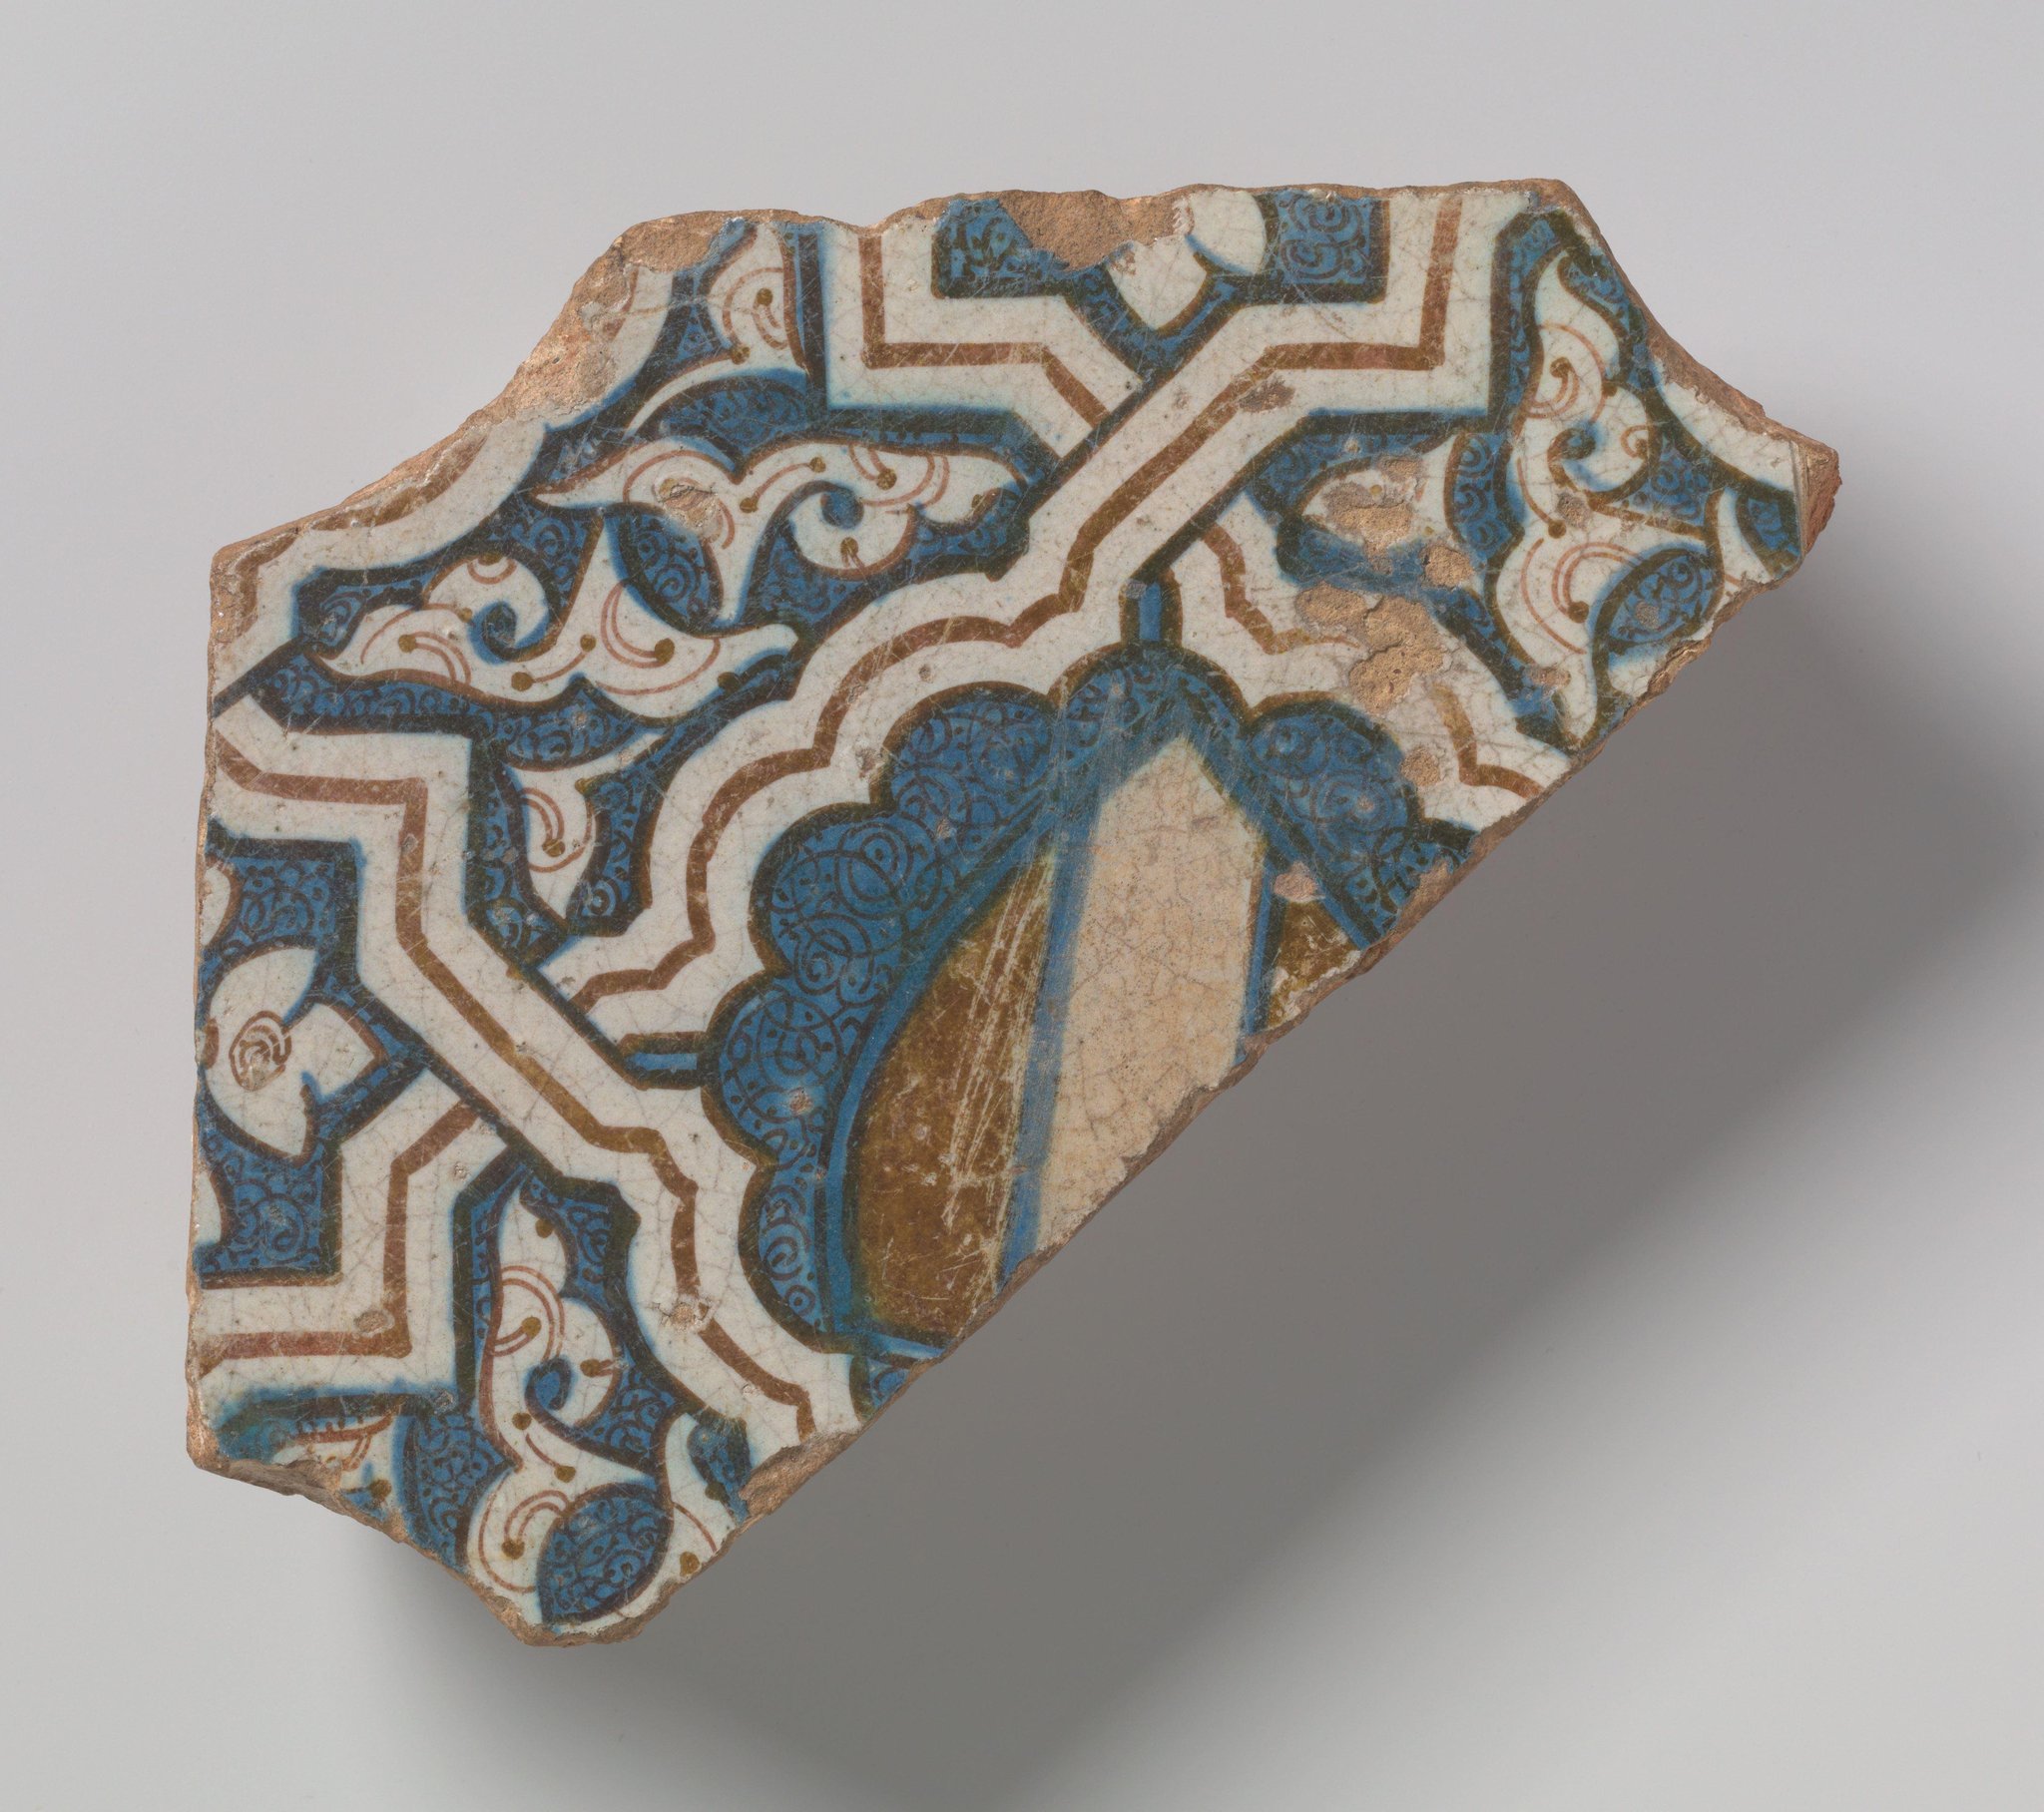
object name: tile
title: Fragment van een tegel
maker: Anonymous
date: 1350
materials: earthenware, glaze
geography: spain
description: Fragment van een tegel, dik tinglazuur, beschilderd in wit, blauw, en goudluster. Vlechtwerk van witte banden die blauwe veelhoeken omsluiten. In deze veelhoeken een versiering in goudluster, in een van de velden een deel van een wapenschild.